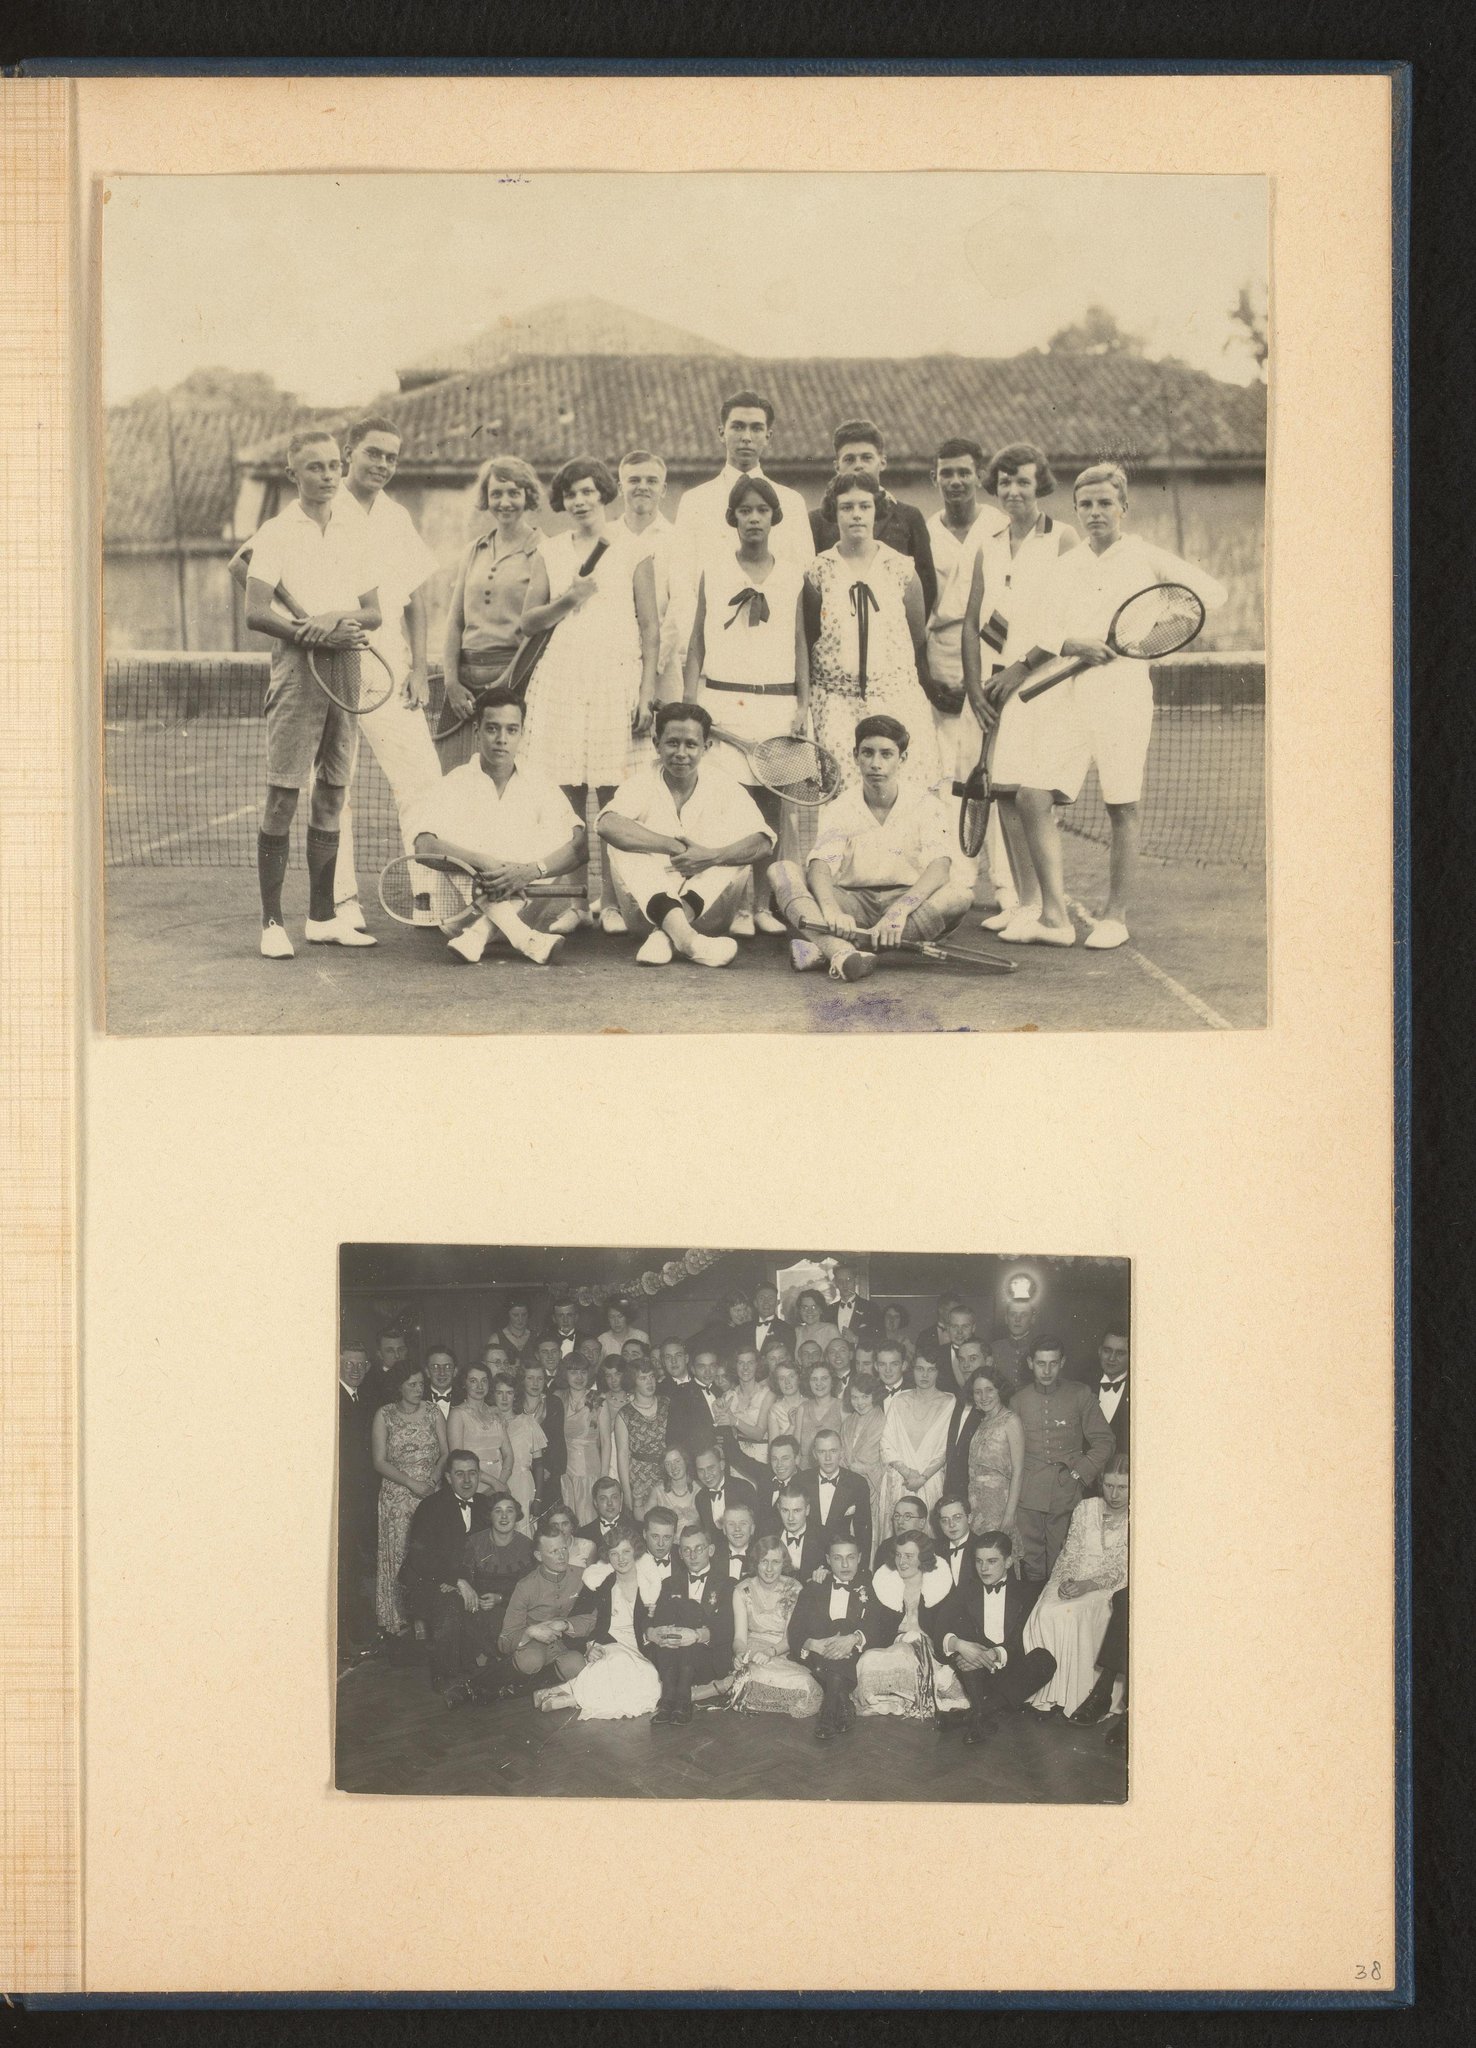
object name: album leaf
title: Tennisclub en galabal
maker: Anonymous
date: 1930-1946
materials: cardboard, photographic support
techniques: gelatin silver print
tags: surabaya, paris, beatrice jacqueline eveline dumas, ball, formal dance, tennis, lawn-tennis (+ sportsman, player, etc.), netherlands, dutch east indies, the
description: Blad met een twee groepsfoto van de spelers van een tennisclub (waaronder Eef en Han Dumas) in Nederlands-Indië en van de jonge mannen en vrouwen in avondkleding op een bal. Onderdeel van het fotoalbum van Beatrice Jacqueline Eveline (Eef) Dumas, ca. 1880-1952.